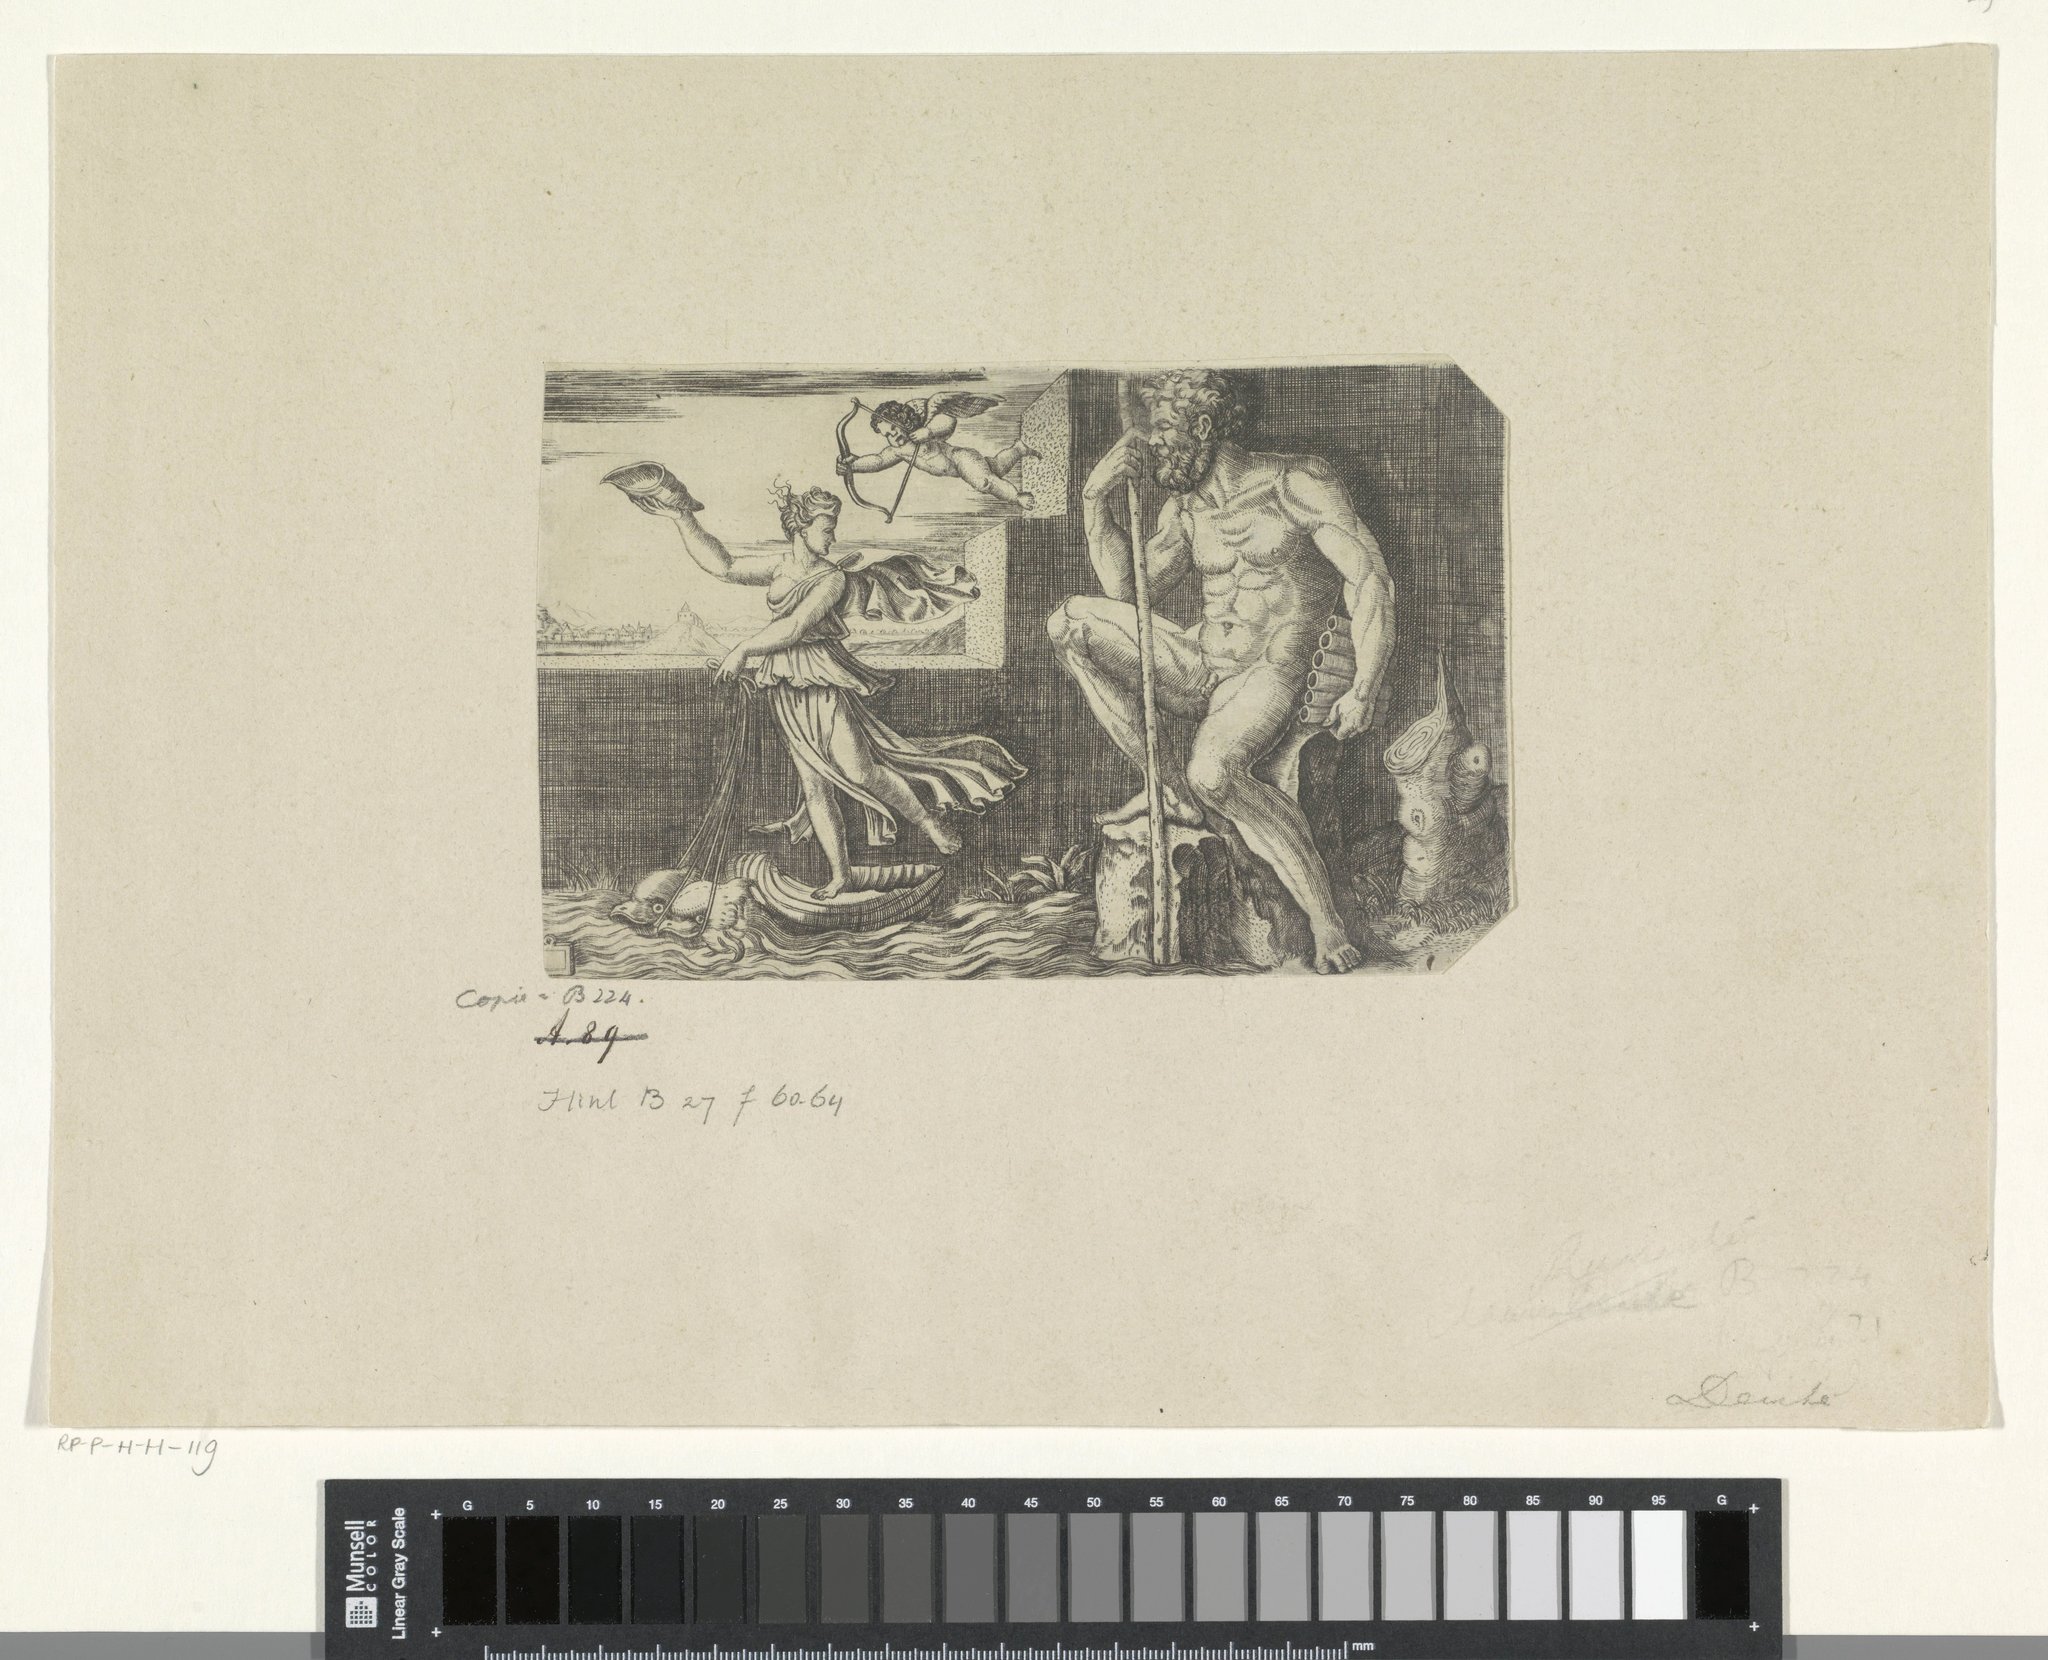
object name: print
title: Galatea ontsnapt aan Polyphemus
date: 1498-1532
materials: paper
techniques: engraving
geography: italy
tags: triumph of galatea, polyphemus playing the syrinx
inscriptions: collector's mark: ‘Hinloopen’, collector's mark: Lugt 11, collector's mark: Lugt 10, number: ‘1’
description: Galatea, rijdend op een door dolfijnen getrokken schelp, ontsnapt aan de cycloop Polyphemus. Polyphemus zit op een rots met een stok en een panfluit in zijn handen. Amor vliegt boven Galatea. Op de achtergrond een muur.